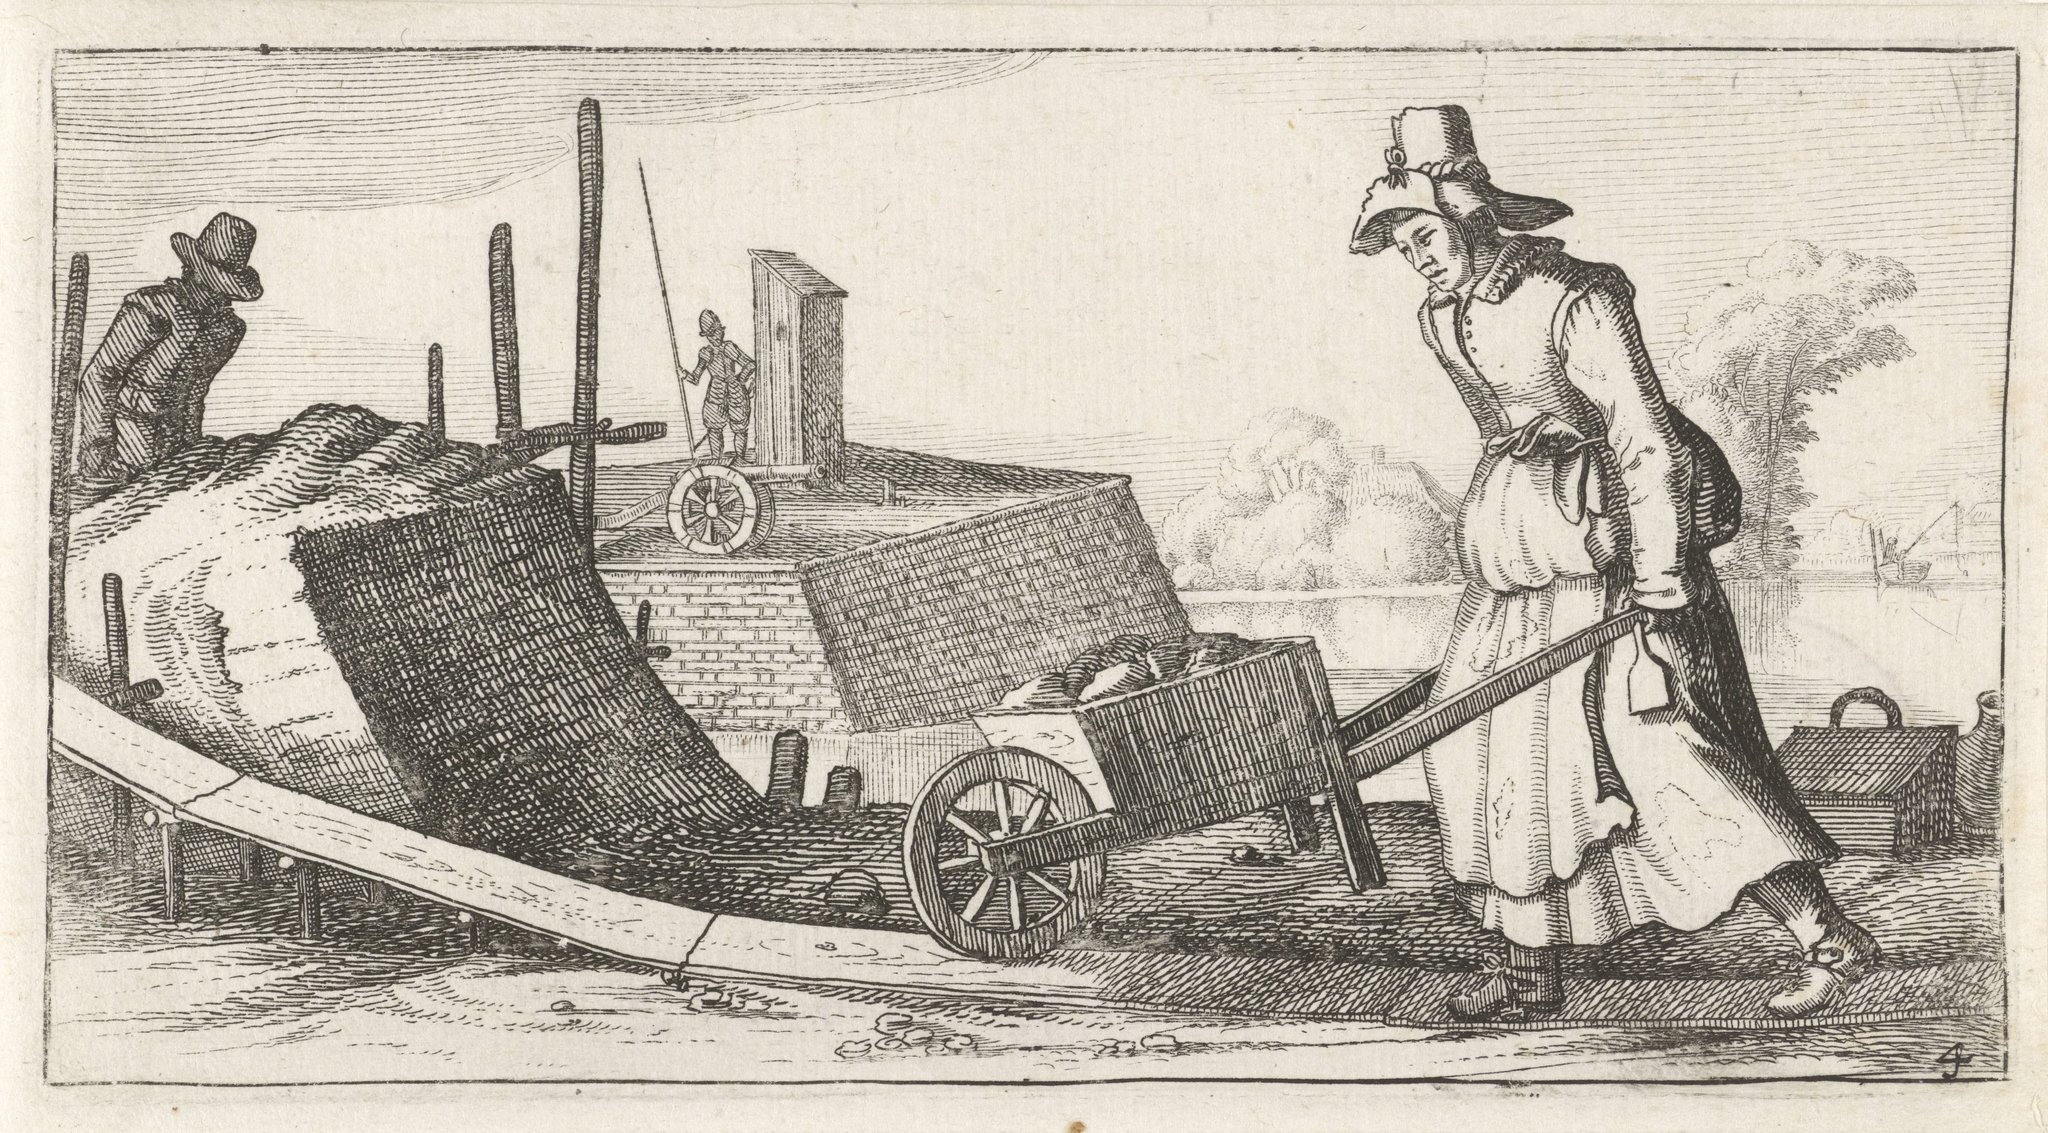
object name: costume print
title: Nederlandse vrouwen- en mannenkostuums, 1622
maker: dirk eversen lons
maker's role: print maker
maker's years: 1599-1686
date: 1622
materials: paper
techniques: engraving, etching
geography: amsterdam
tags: transport of building materials, hand-cart, dress, gown (+ women's clothes), building-site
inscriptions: collector's mark: Lugt 240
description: Kleding: vilthoed met grote opgeslagen rand. Kleine schouderkleppen. Plat kraagje met randversiering, opgeslagen rok. Schort. Hoog gesloten lijfje met knoopsluiting en nauwe mouwen. Schoenen met ronde neus, platte hak en vetersluiting. Hoewel kleding van boerenvrouw; toch verschillende modeverschijnselen gevolgd.